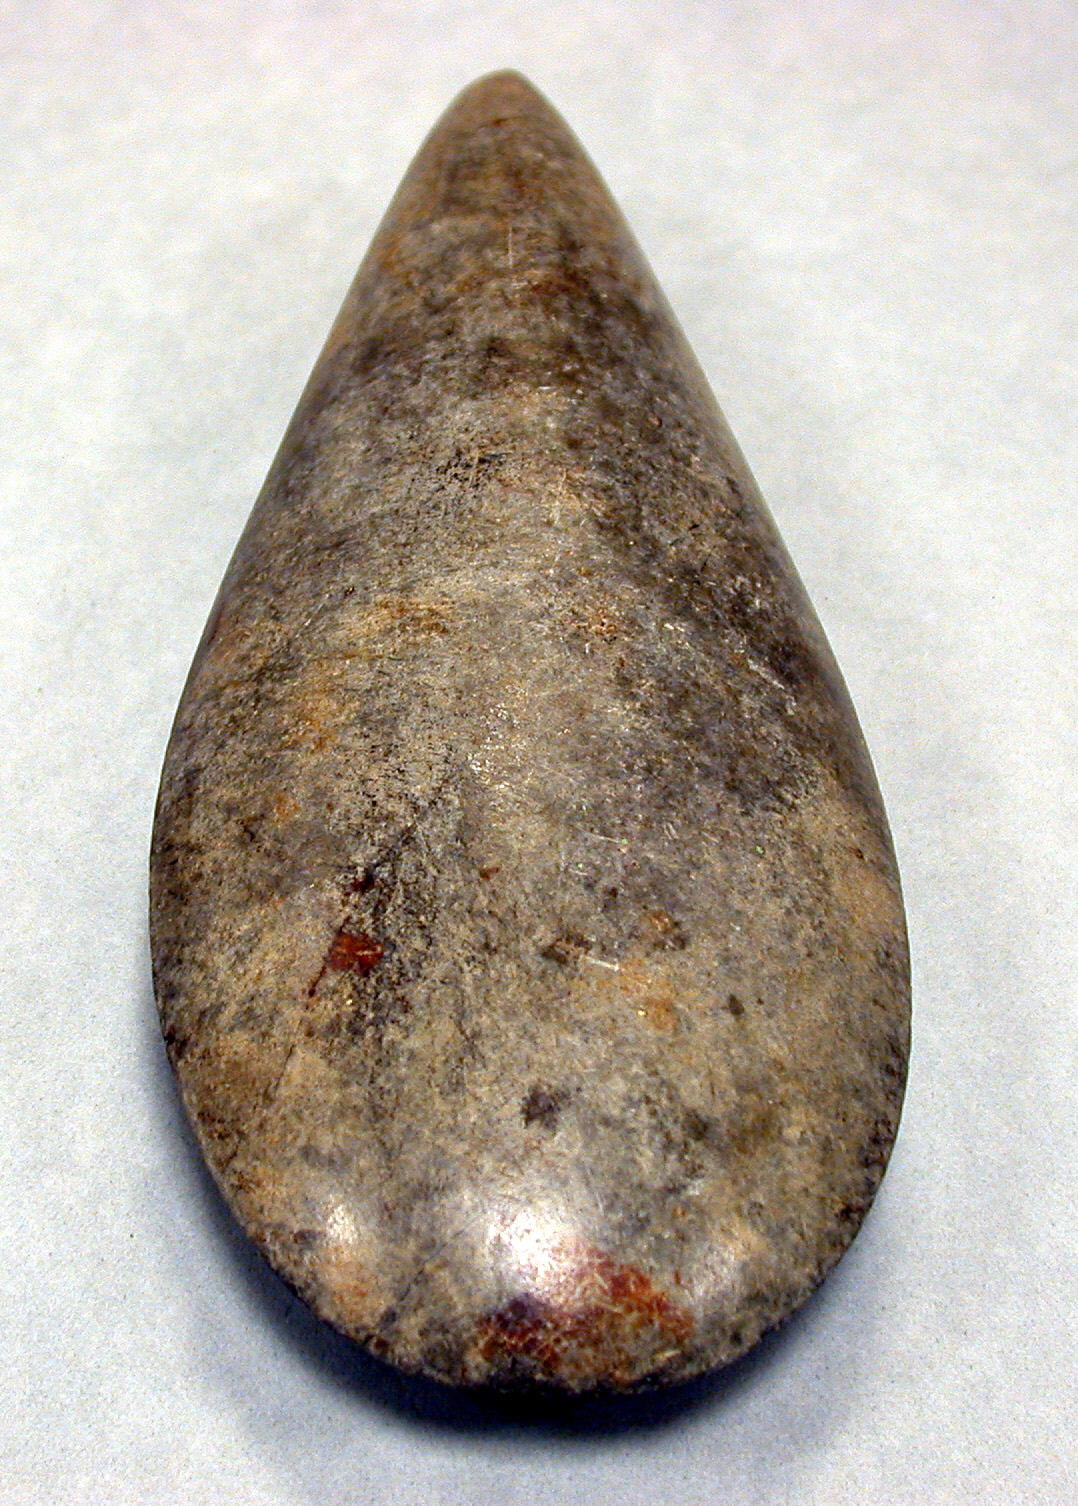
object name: celt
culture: taíno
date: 601-1000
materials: stone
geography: puerto rico